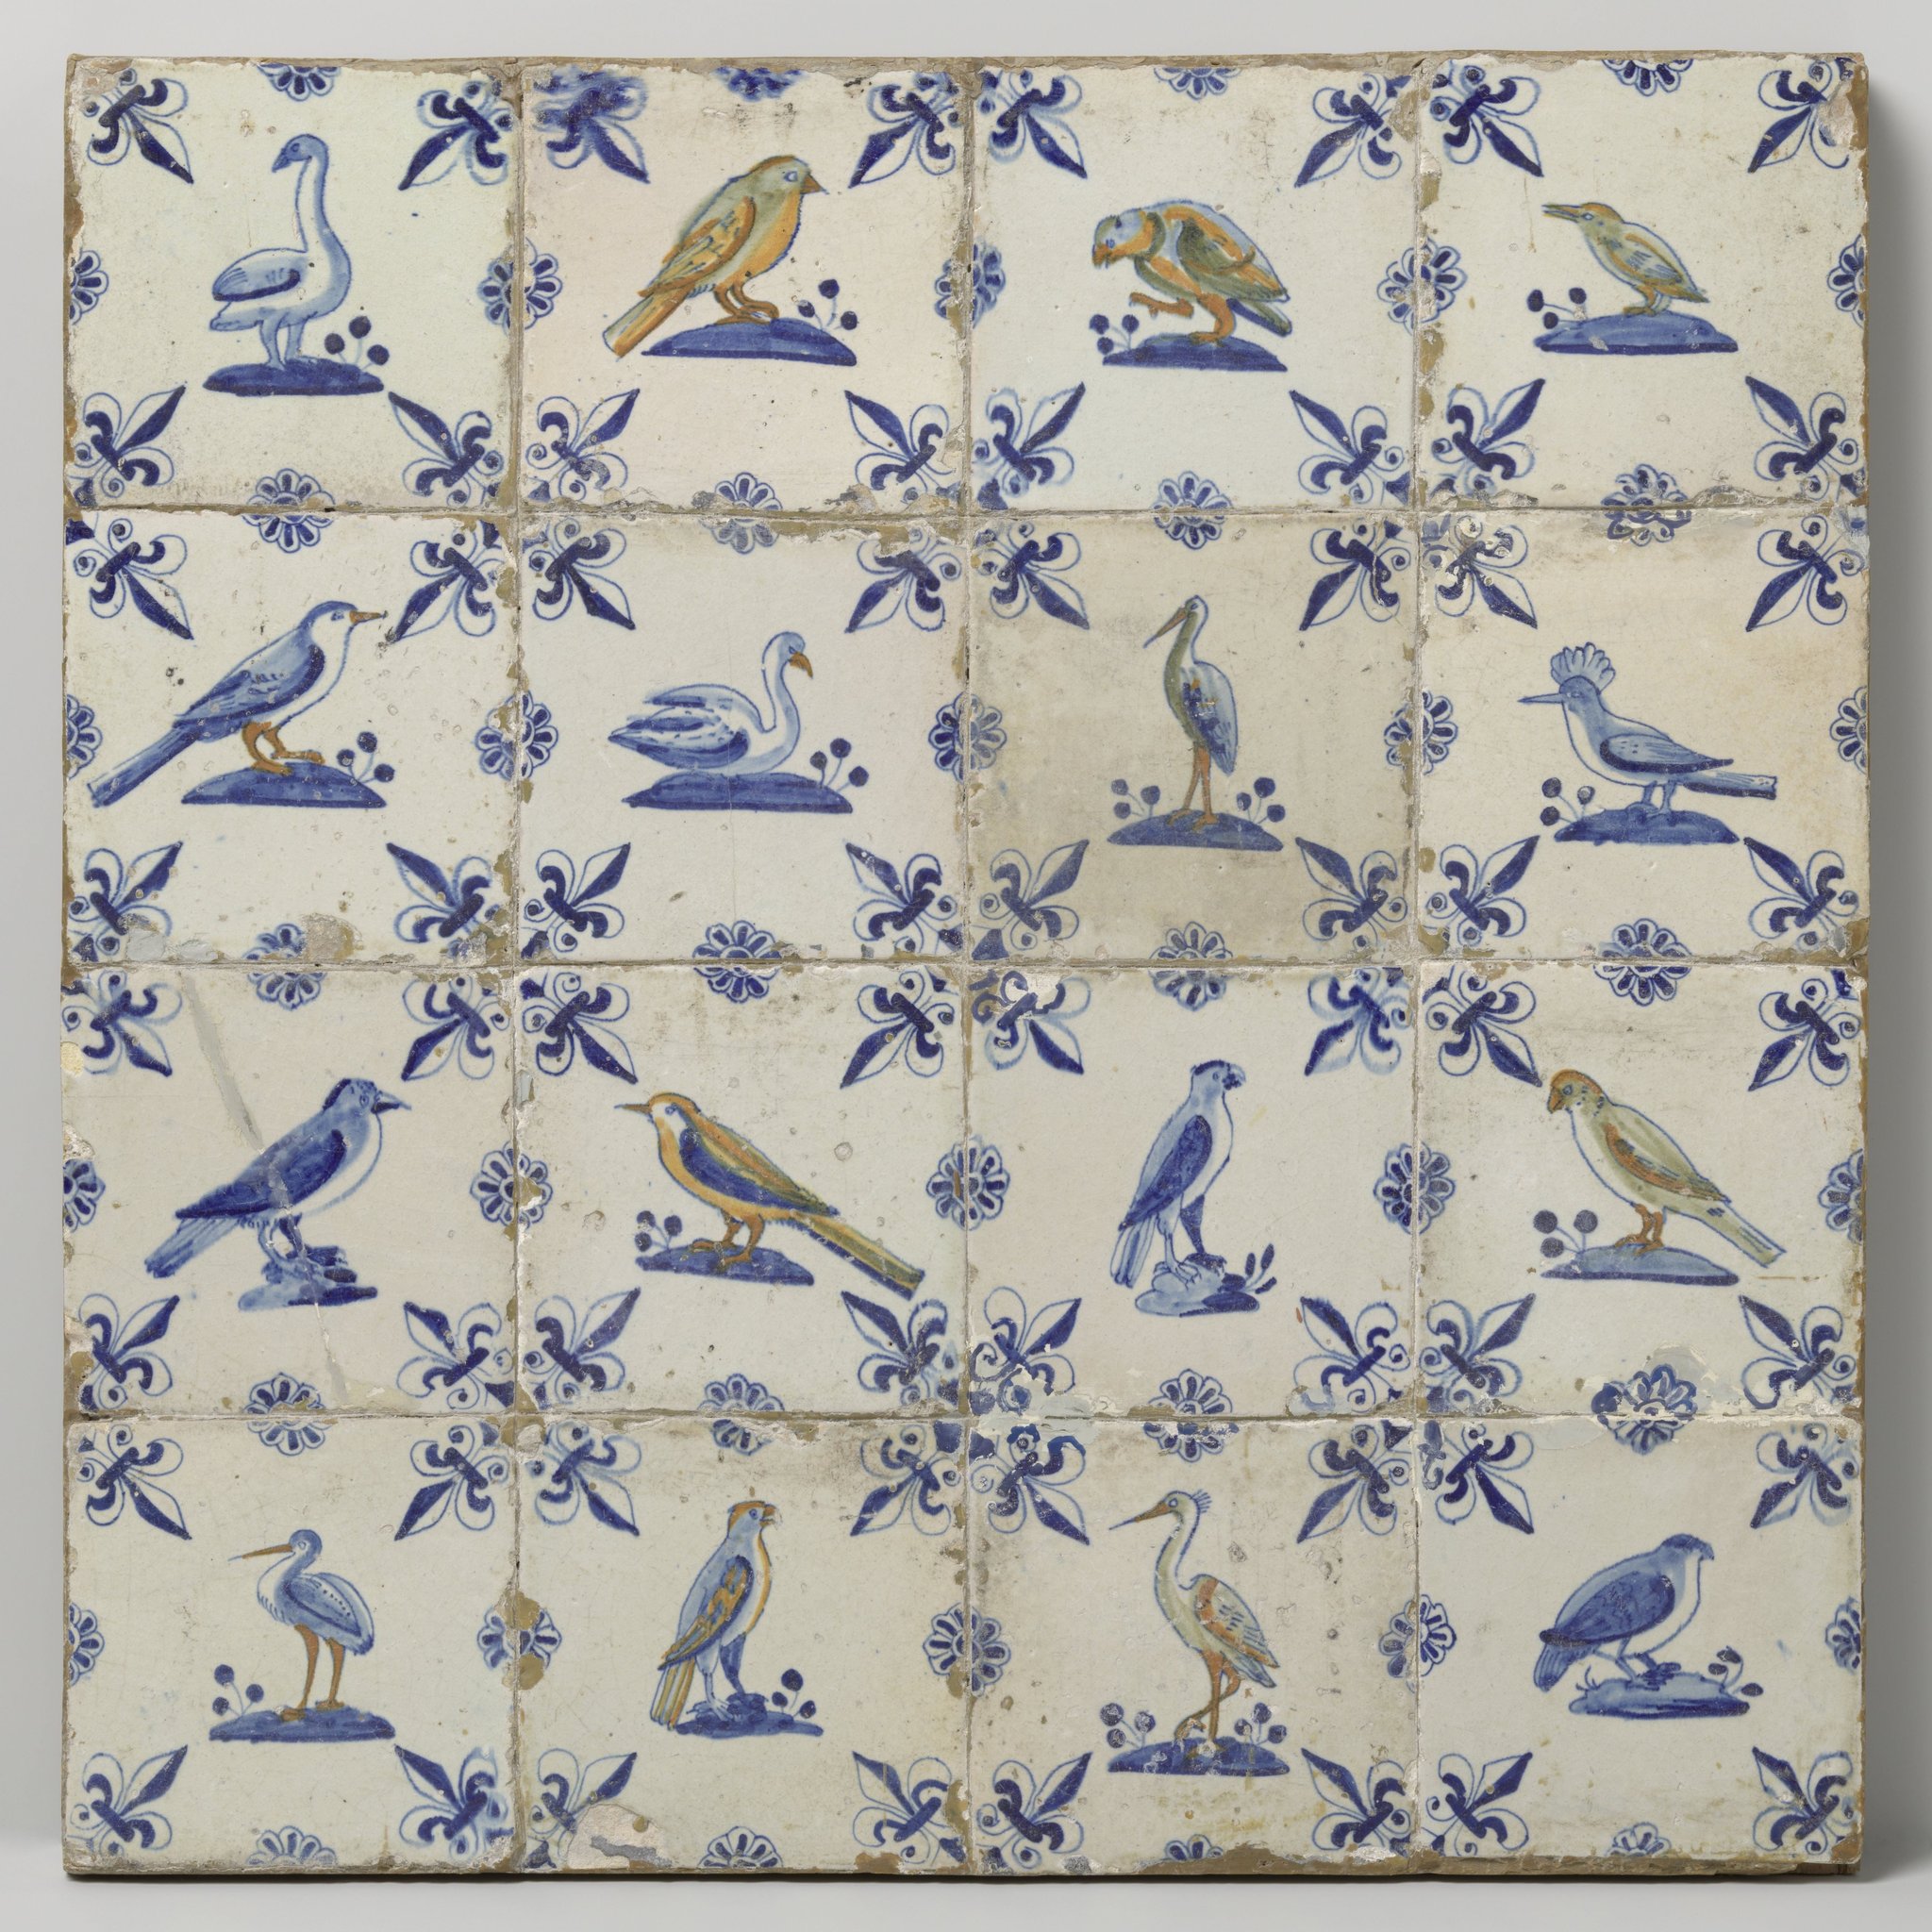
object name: tegelveld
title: Veld van zestien tegels met vogels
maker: Anonymous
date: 1640-1660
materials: earthenware, glaze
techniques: maiolica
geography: netherlands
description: Veld van zestien tegels (4 x 4) elk met een veelkleurig (blauw, groen en oranje) geschilderde vogel op een grond. Langs de randen een halve rozet en in de hoeken, een lelie.